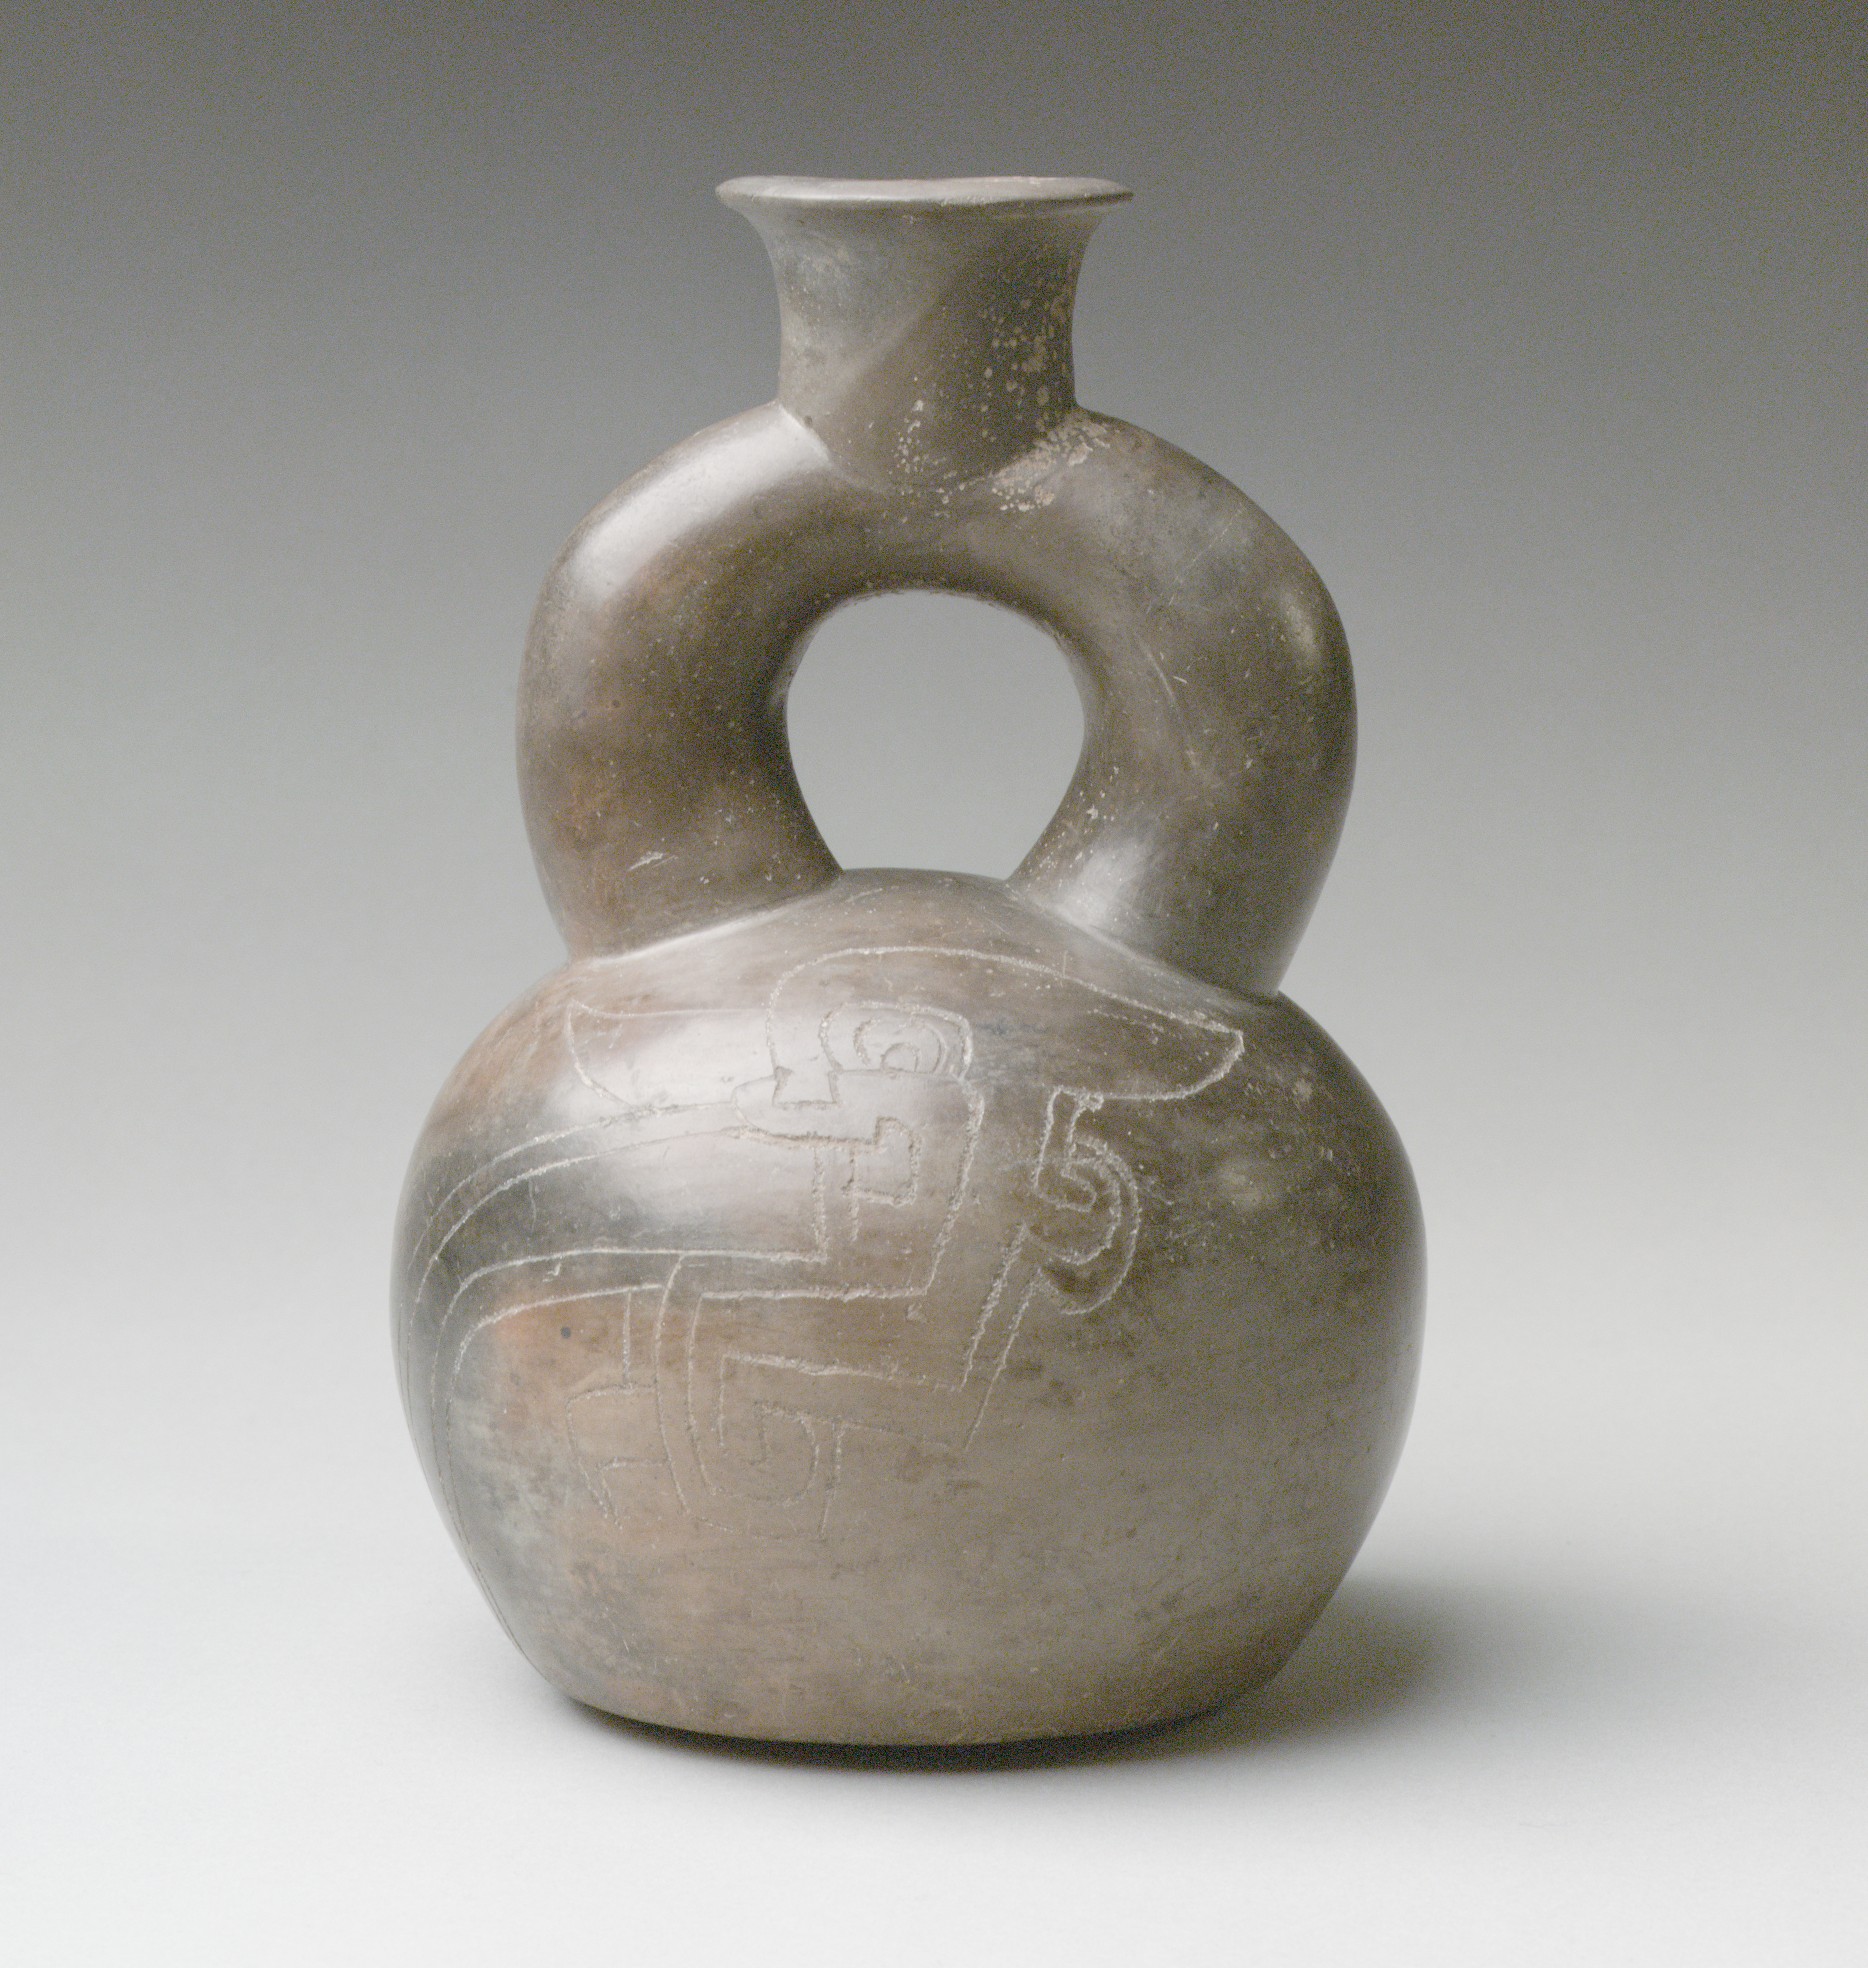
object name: bottle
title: Stirrup-Spout Bottle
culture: cupisnique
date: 1200-401 BCE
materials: ceramic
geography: peru